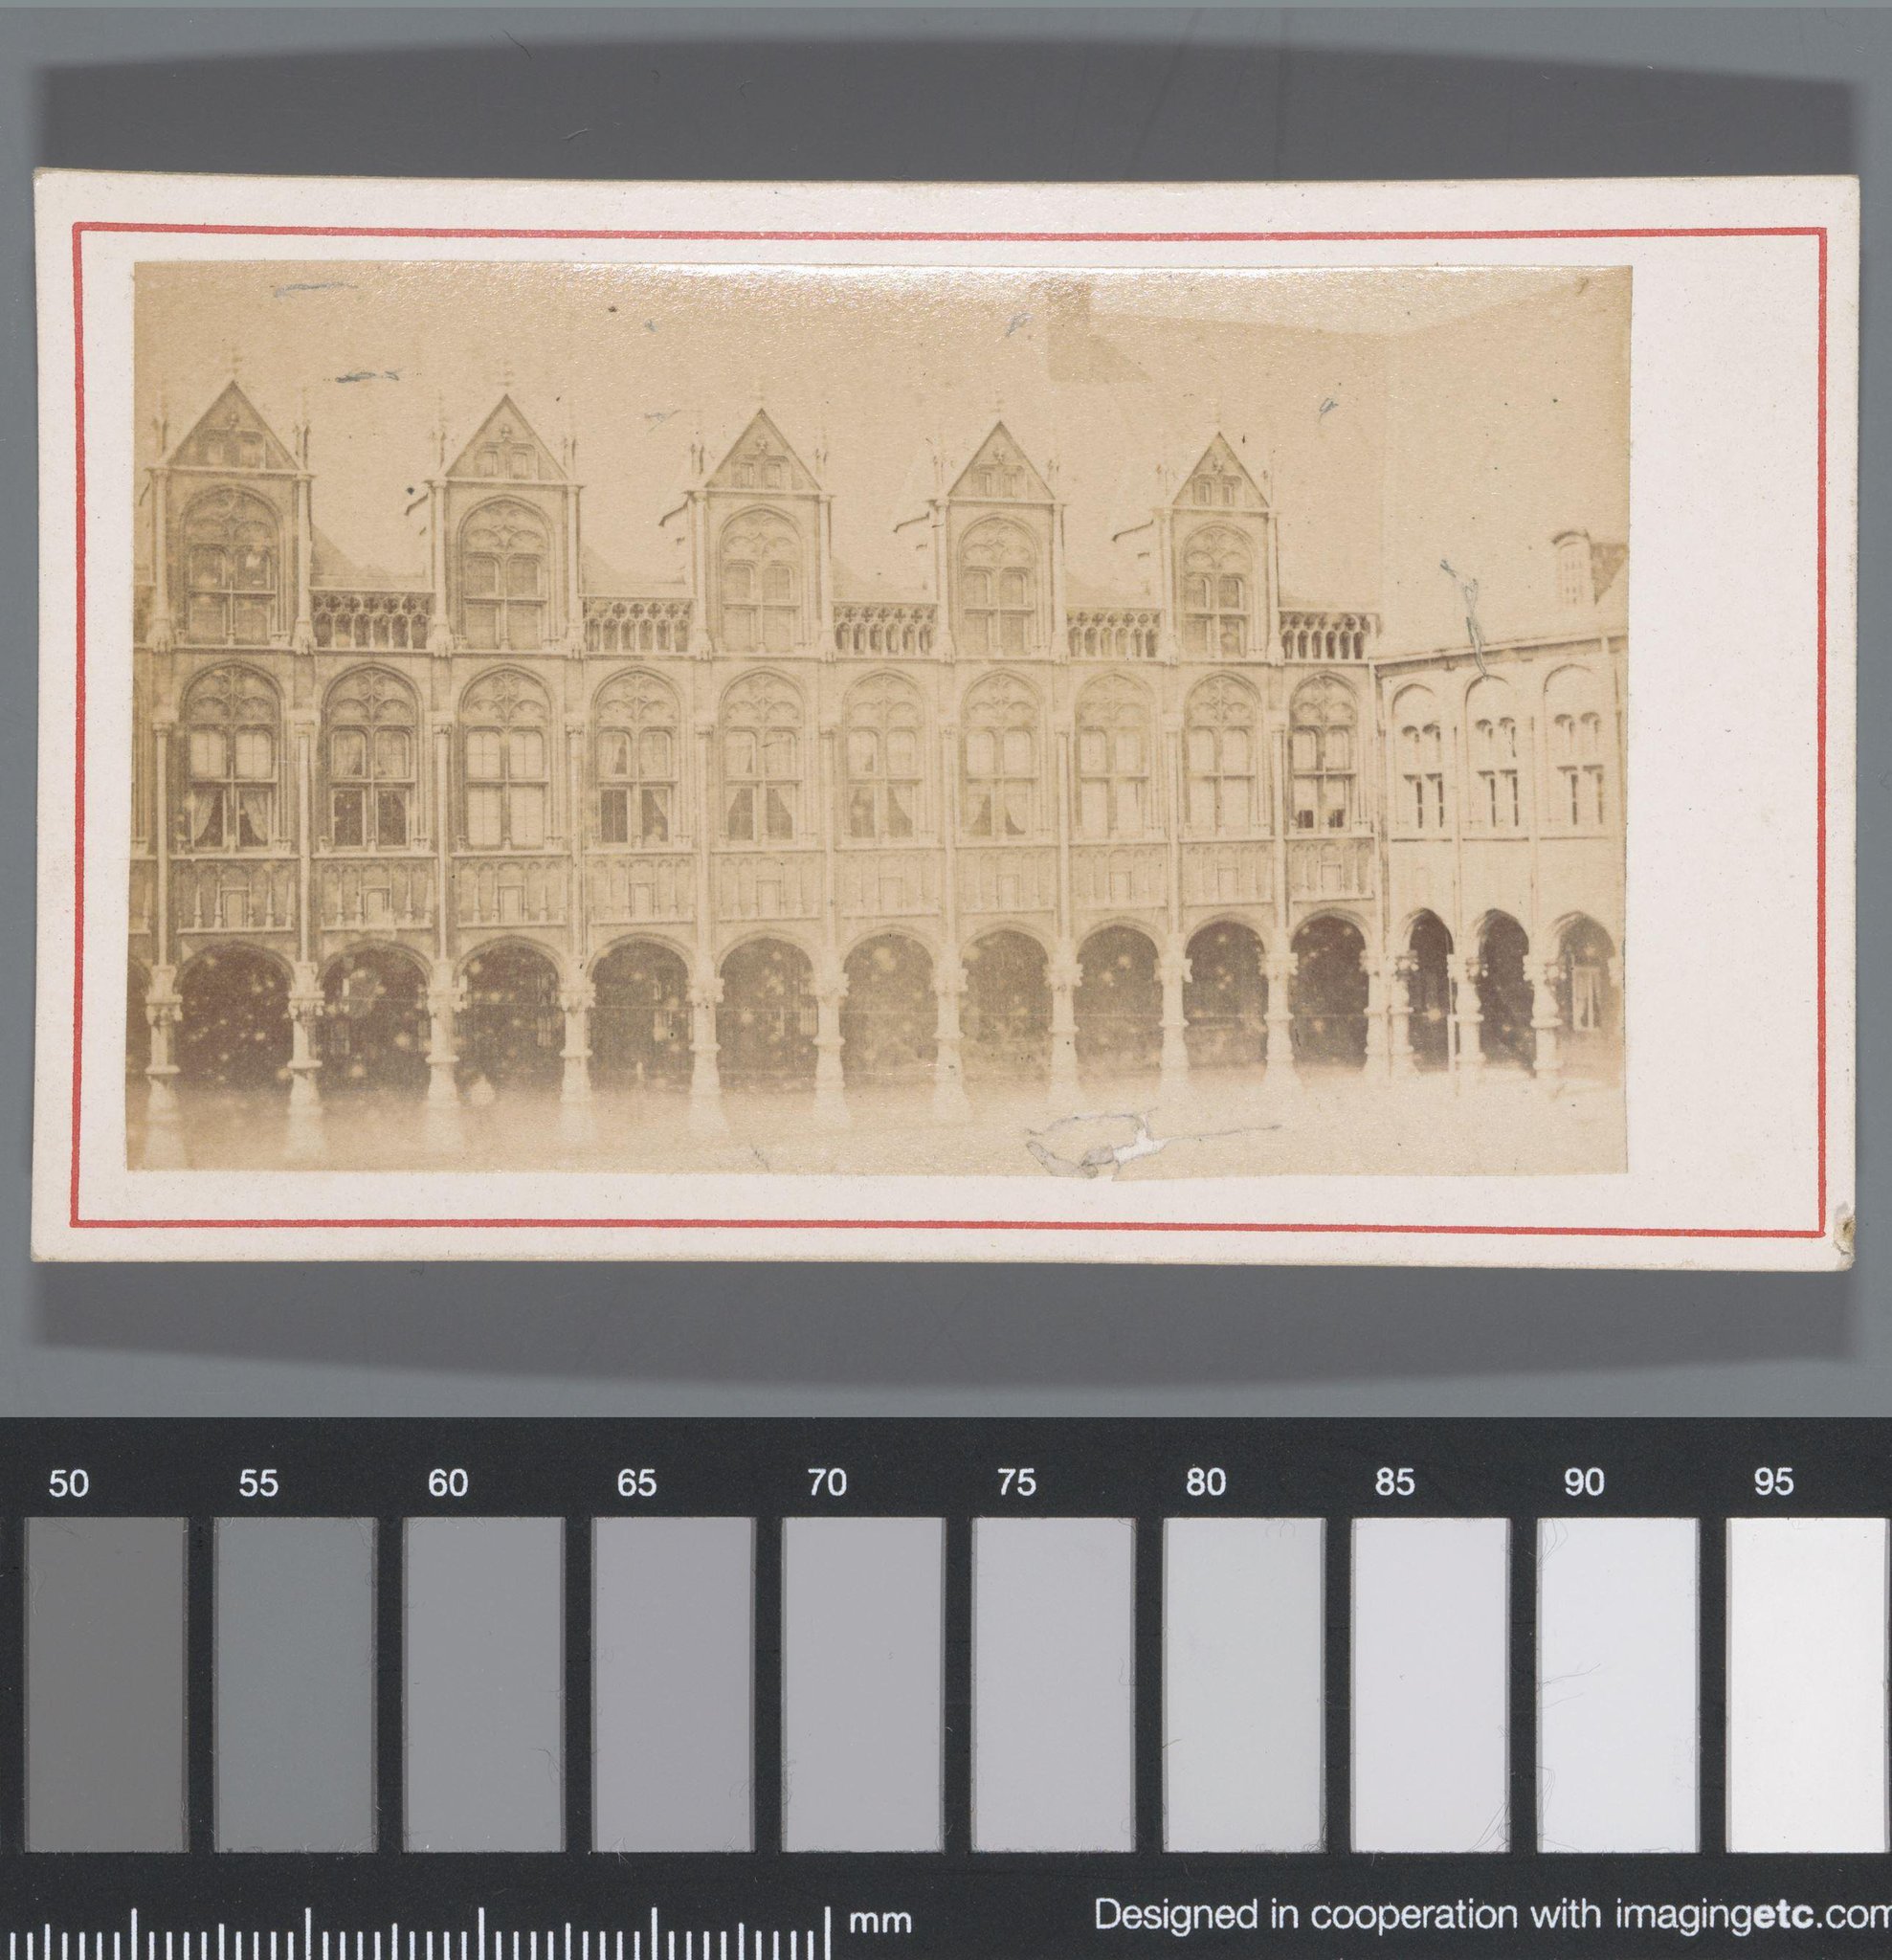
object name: carte de visite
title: Liège, Palais de Justice et palais provencial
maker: Anonymous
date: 1855-1885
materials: cardboard, paper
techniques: albumen print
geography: liège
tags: inner court of palace or 'hôtel'